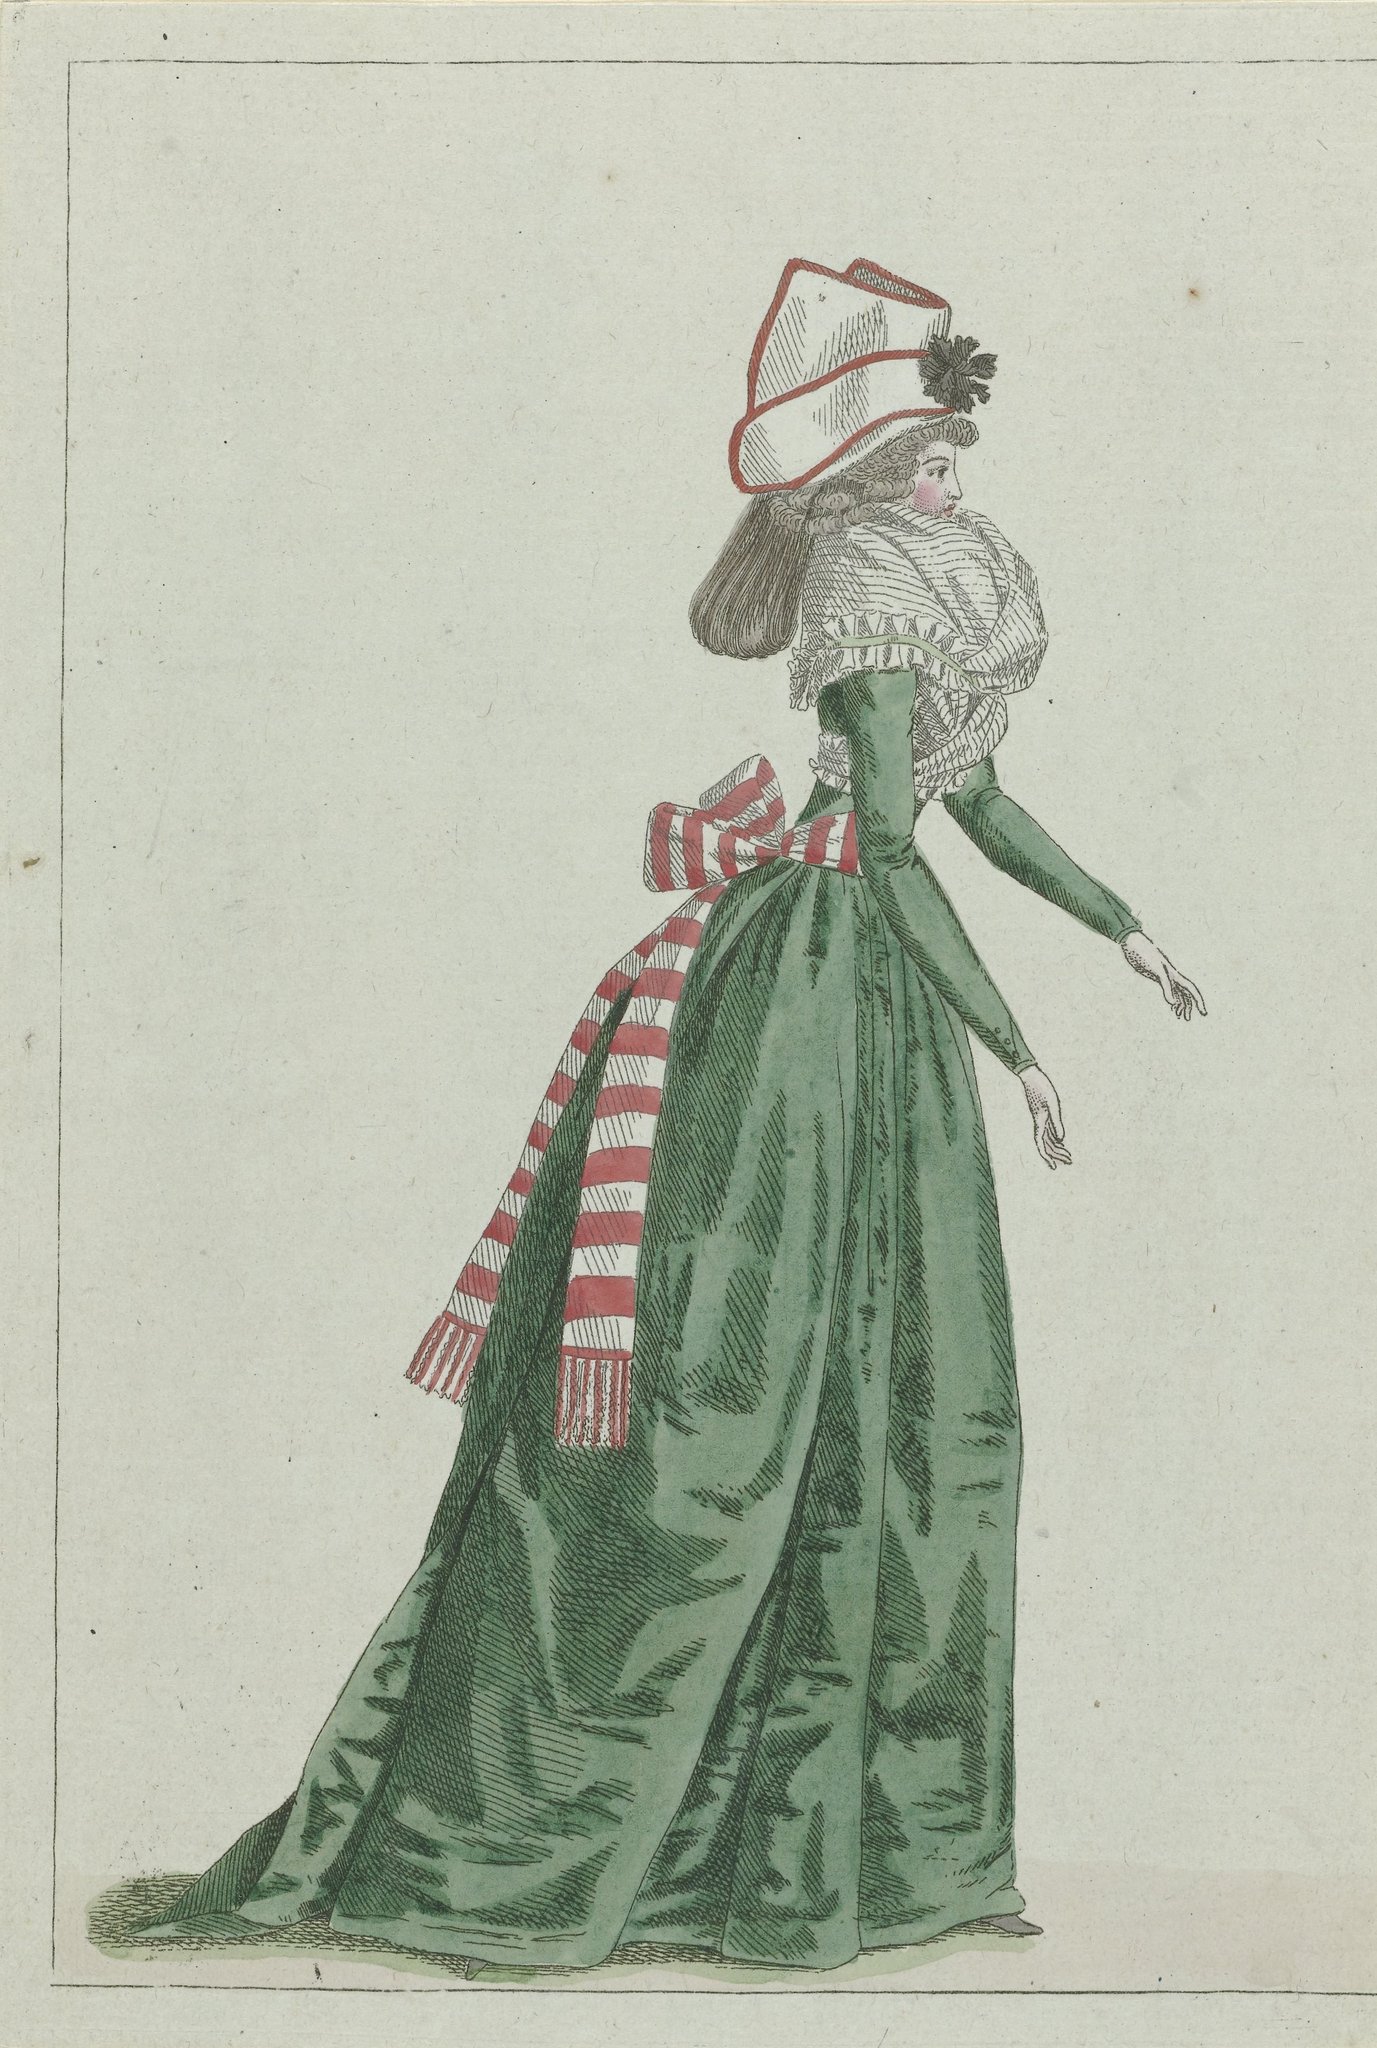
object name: fashion print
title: Fashion News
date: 1791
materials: paper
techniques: engraving, hand coloring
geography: paris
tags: head-gear (bonnet à la paysanne) (+ women's clothes), styles of hairdress - aa - ~ women, fashion plates, sleeves: cuffs (+ women's clothes), dress, gown (+ women's clothes), piece of clothing covering the breast or décolleté (fichu) (+ women's clothes), belt, girdle, waistband (+ women's clothes)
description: The Cabinet des Modes offered readers highly detailed information about the illustrated clothes and accessories. It reported, for instance, on new clothing styles, such as the English ‘redingote’ 1; on accessories and embellishments, such as oversized muffs, buttons, ribbons and clasps; and finally, on the latest interior furnishings. For its male audience there was the fitted jacket 2 and the popular Androsmane, a hat with an upturned brim 3.